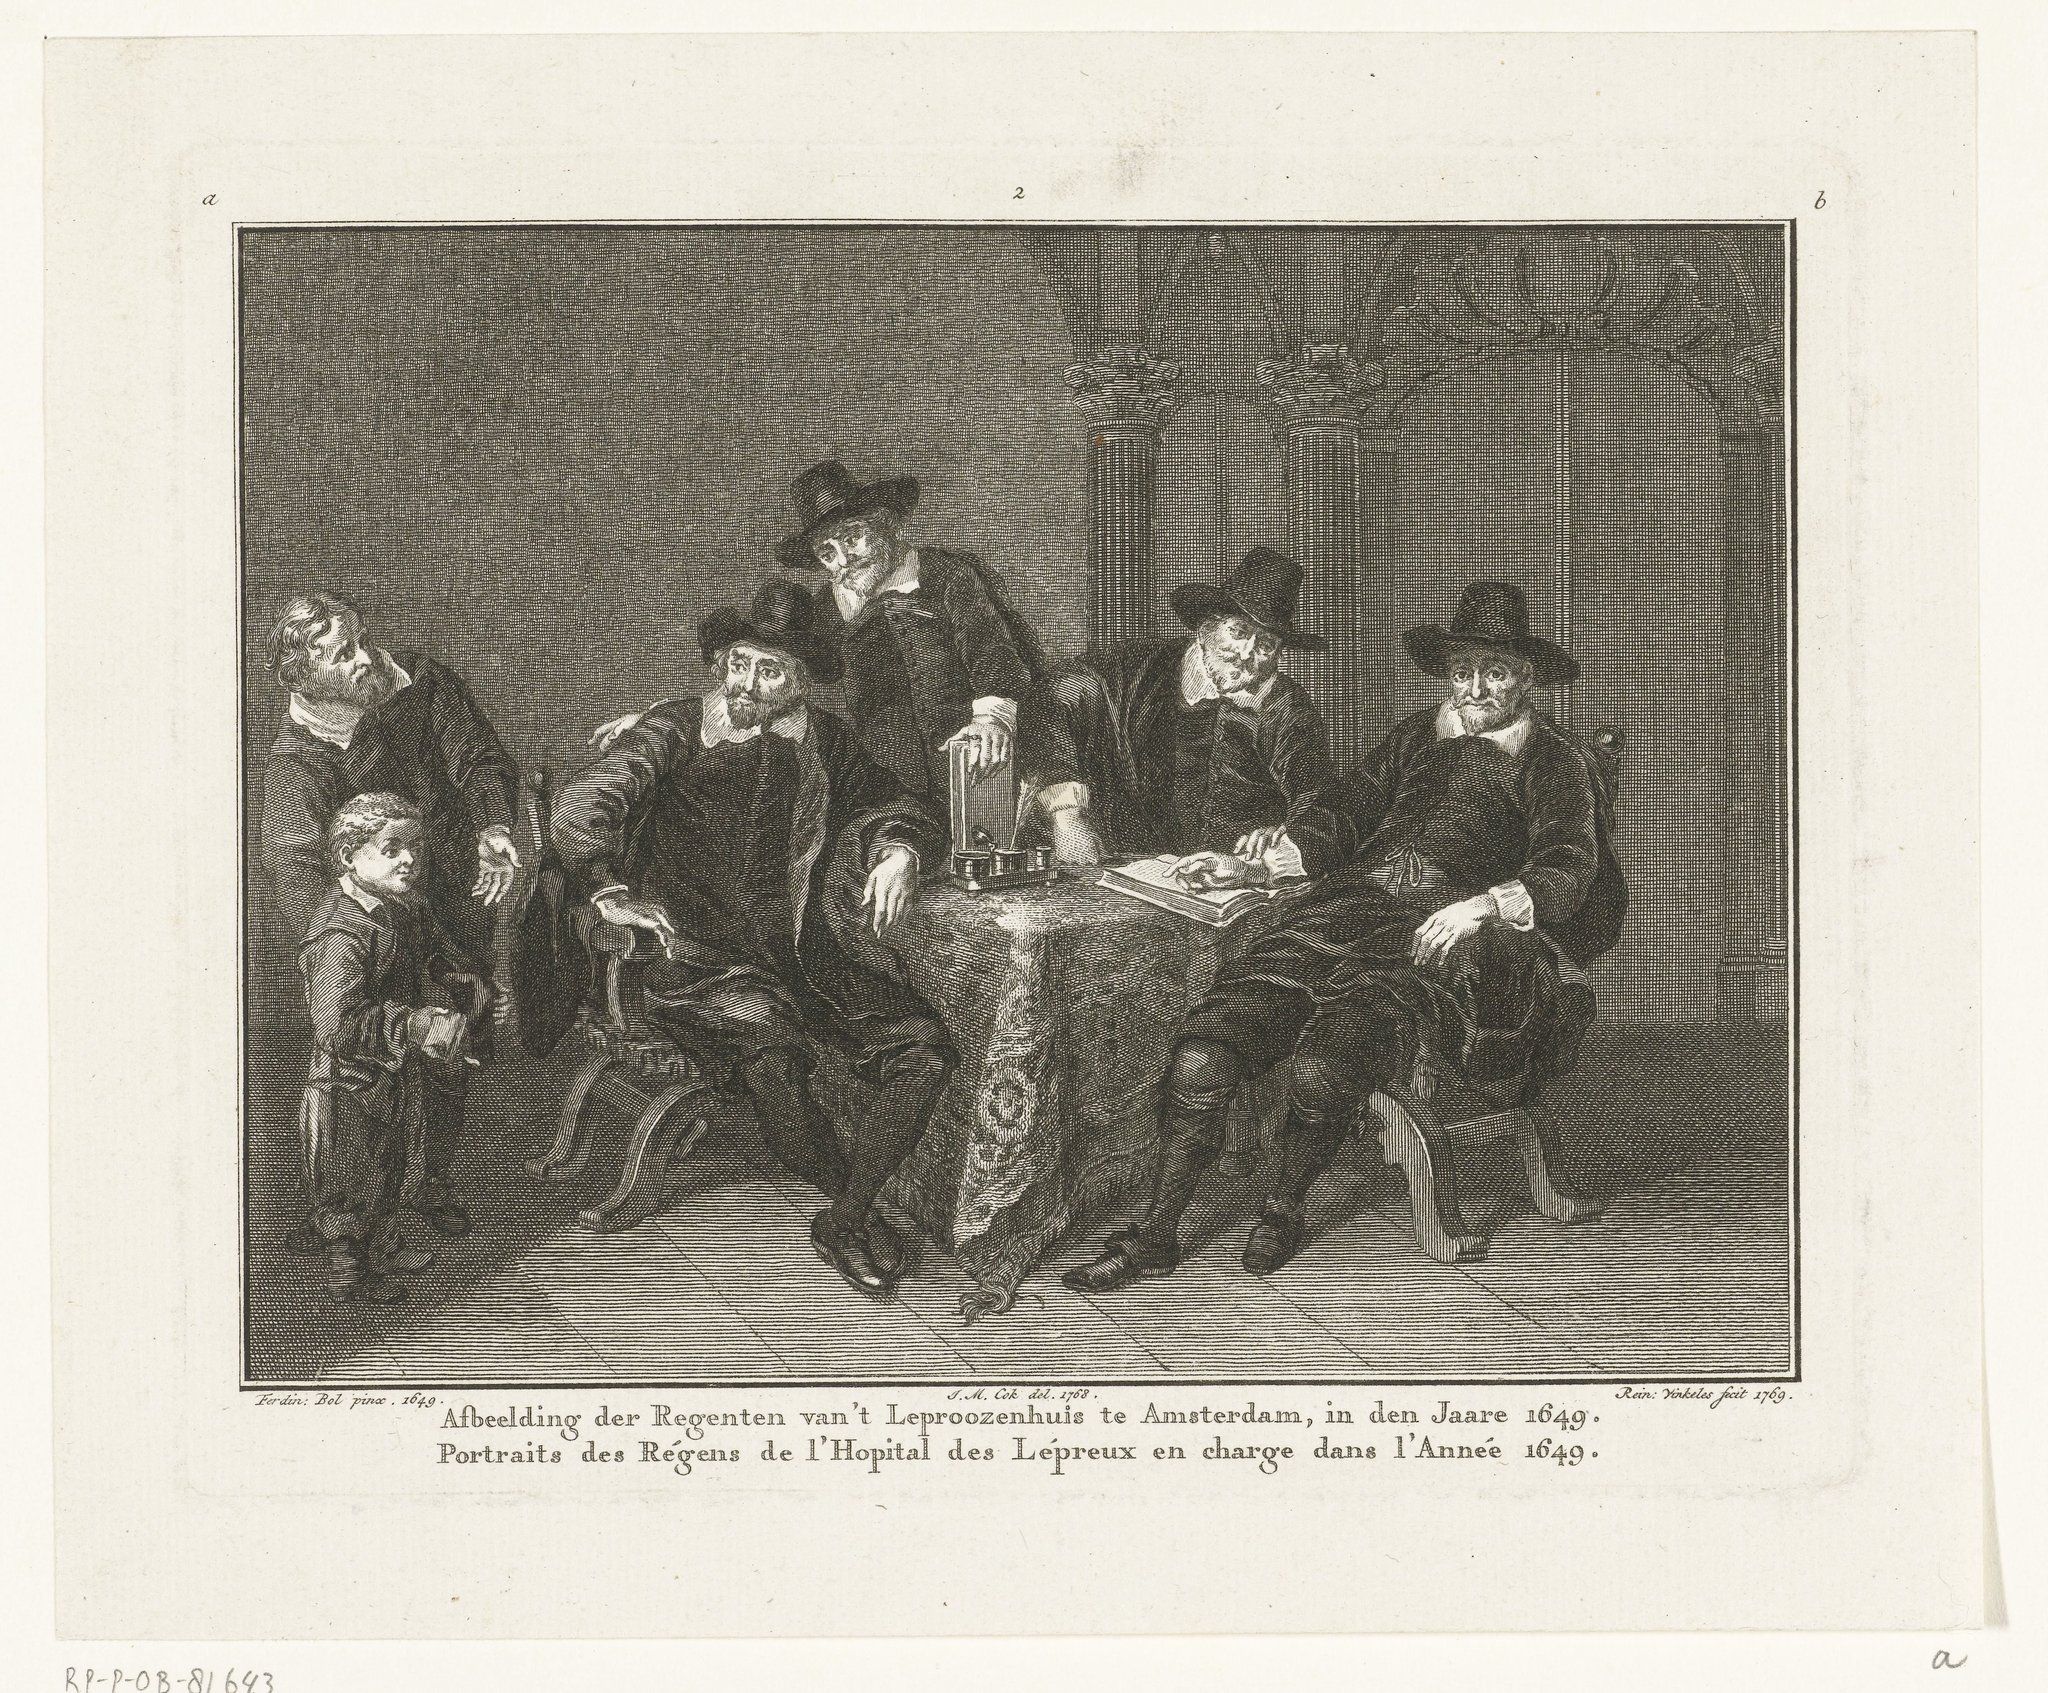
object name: historical object representation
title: Afbeelding der regenten van 't Leproozenhuis te Amsterdam, in den Jaare 1649 / Portraits des Régens de l'Hopital des Lépreux en charge dans l'Année 1649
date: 1769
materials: paper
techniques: etching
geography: netherlands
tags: leprosarium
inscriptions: date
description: Groepsportret van de regenten van het Leprozenhuis, geschilderd door Ferdinand Bol in 1649. Een vergadering van de regenten wordt onderbroken door de binnenvader die een ziek kind binnen leidt.